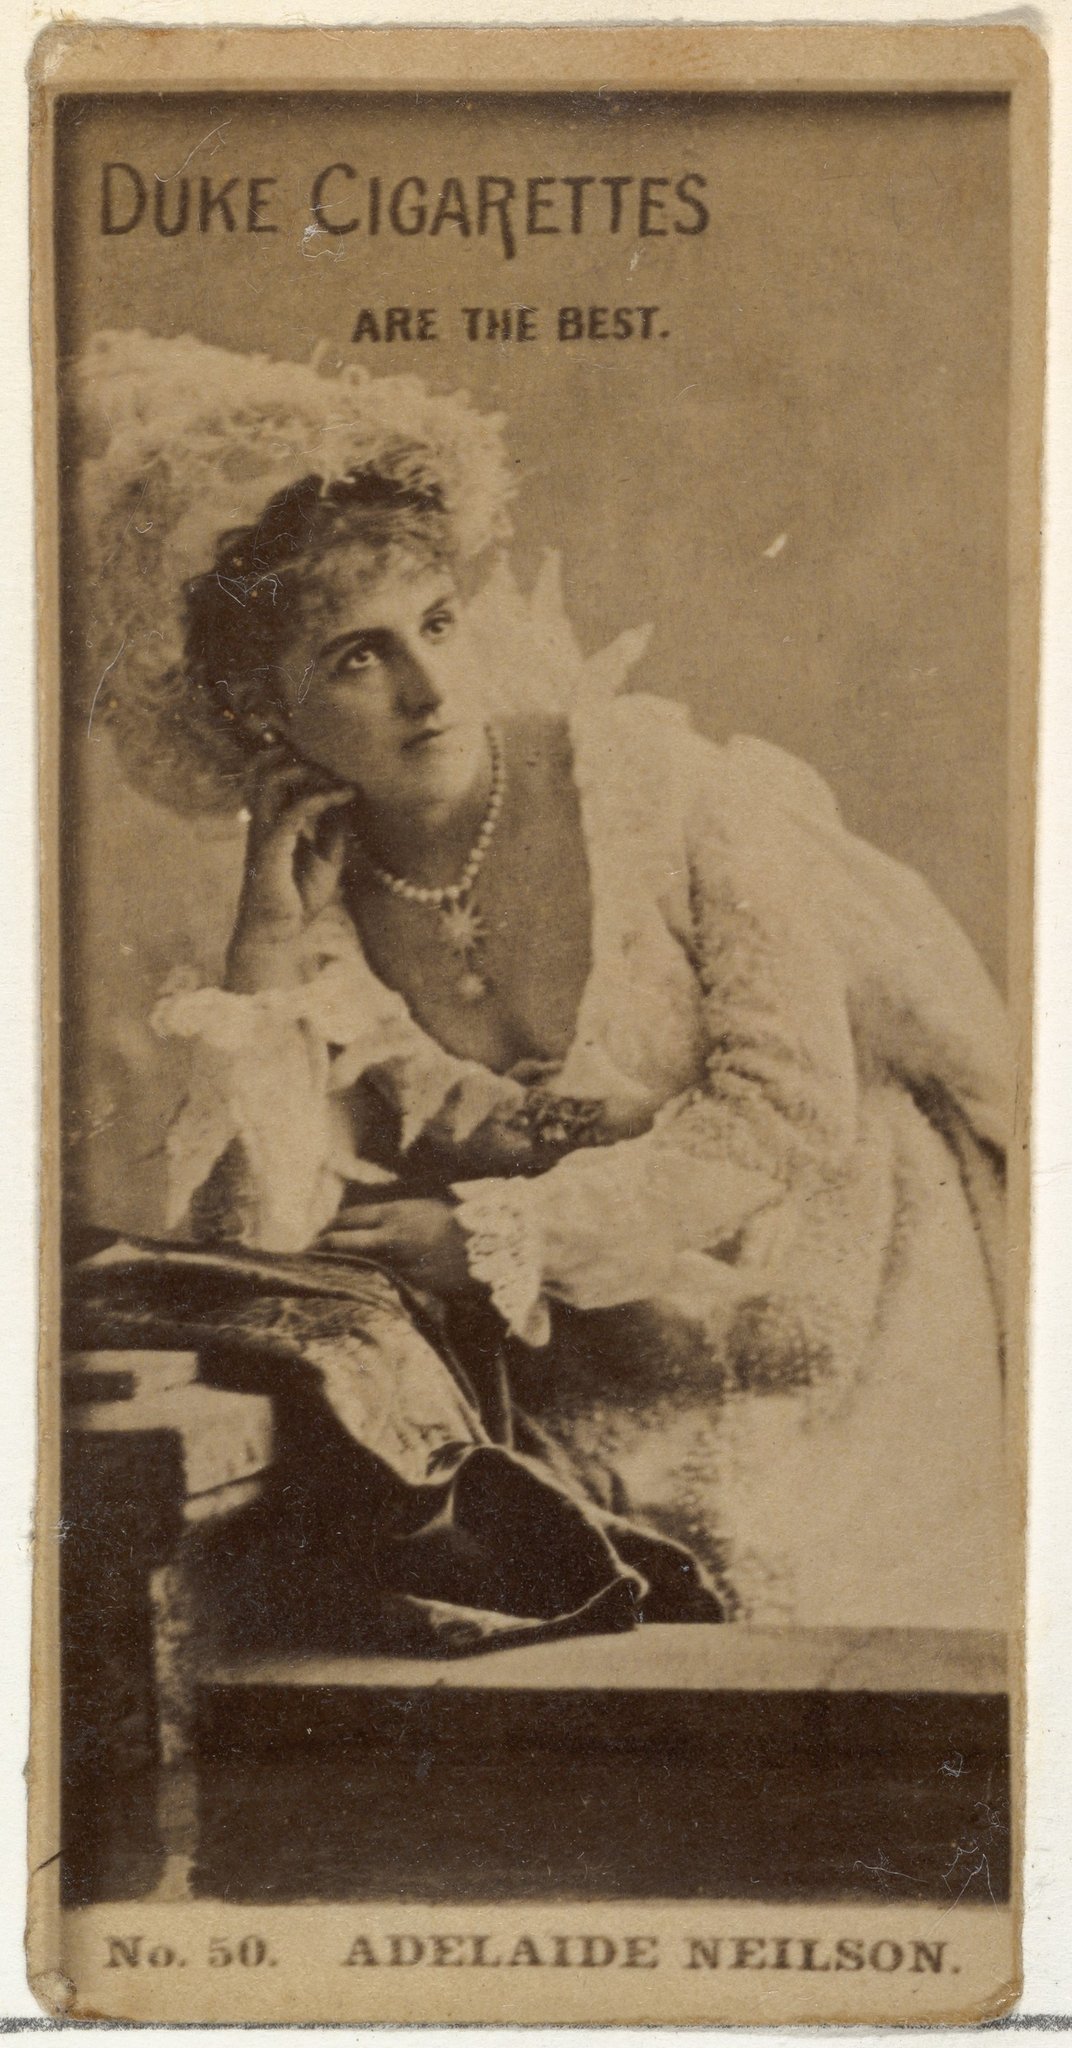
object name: photograph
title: Card Number 50, Adelaide Neilson, from the Actors and Actresses series (N145-6) issued by Duke Sons & Co. to promote Duke Cigarettes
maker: w. duke, sons & co.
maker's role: publisher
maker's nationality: american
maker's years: 1870-1920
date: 1880-1889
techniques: albumen silver print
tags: portraits,women,actresses